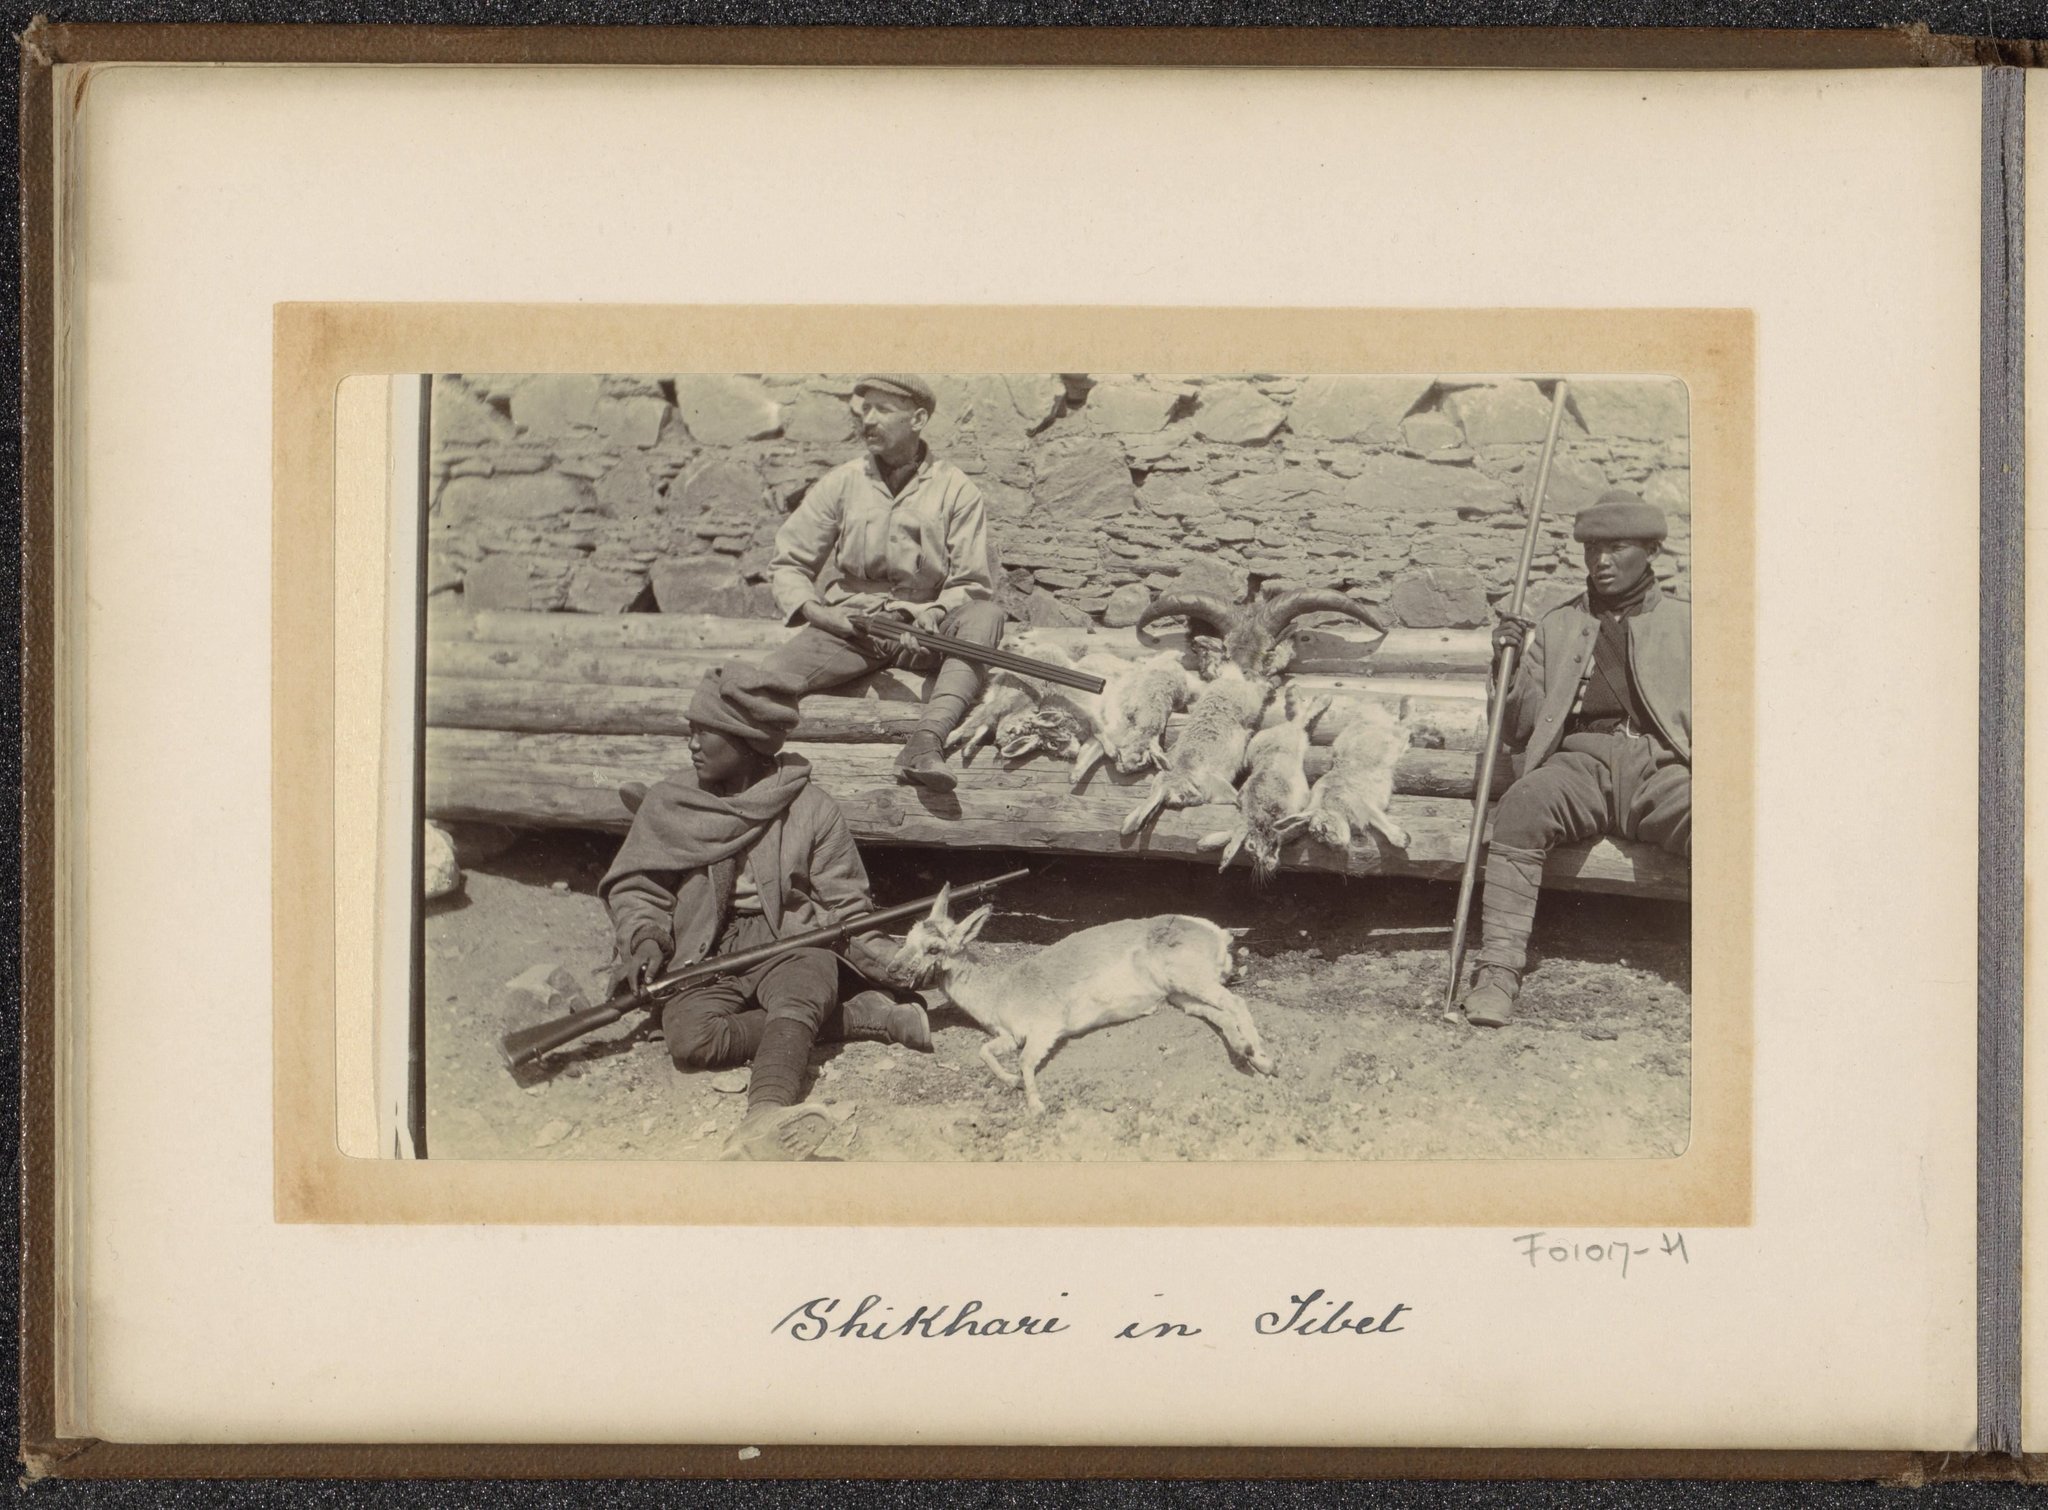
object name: photograph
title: Shikaris (hunters), an Englishman and hunting booty in Tibet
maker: d.t. dalton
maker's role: sergeant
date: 1903-1906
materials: photographic support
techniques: gelatin silver print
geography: tibet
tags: group-portrait of hunters, clothes for special purposes, spoils of the hunt, game, venison, firearms: rifle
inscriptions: title: ‘Shikhari in Tibet’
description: Onderdeel van Fotoalbum met 24 foto's van de reis van legertelegrafist D.T. Dalton door Tibet.